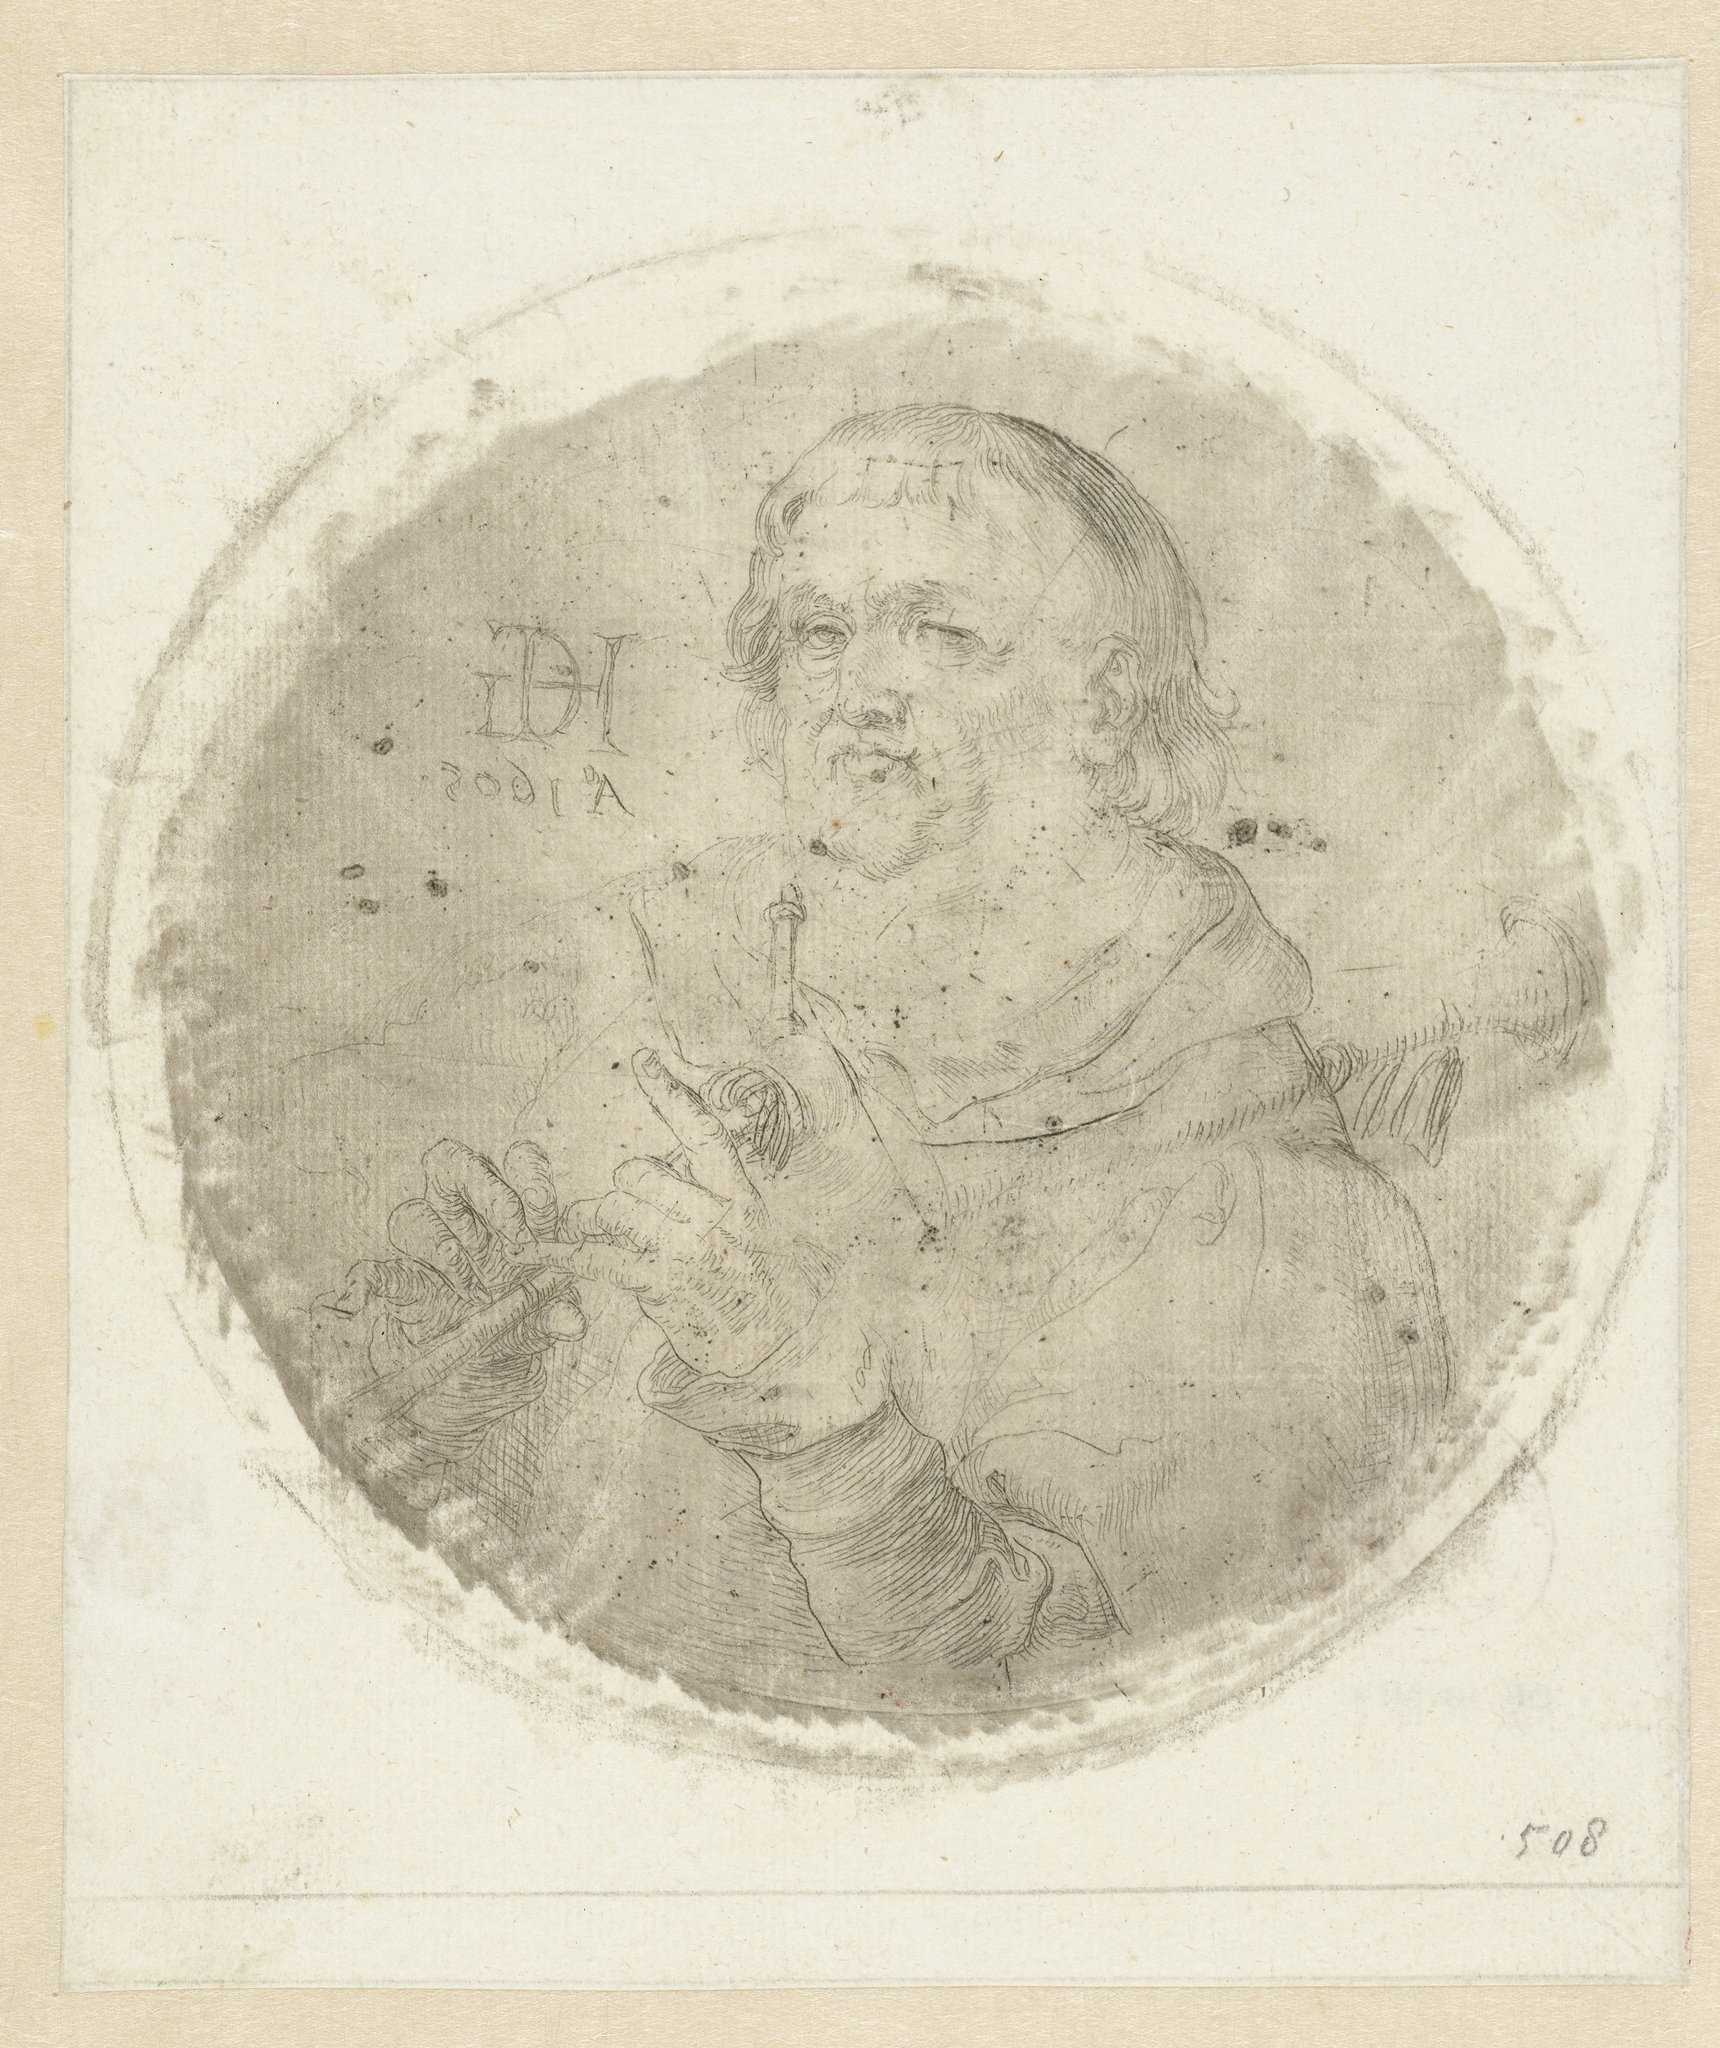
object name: print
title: Doedelzakspeler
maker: hendrick goltzius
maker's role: draughtsman, painter, print maker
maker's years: 1558-1617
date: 1605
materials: paper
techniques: etching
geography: haarlem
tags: bagpipe, musette, anonymous historical person portrayed alone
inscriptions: collector's mark: Lugt 240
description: Onvoltooid, rond portret ten halven lijve van een man met een doedelzak.